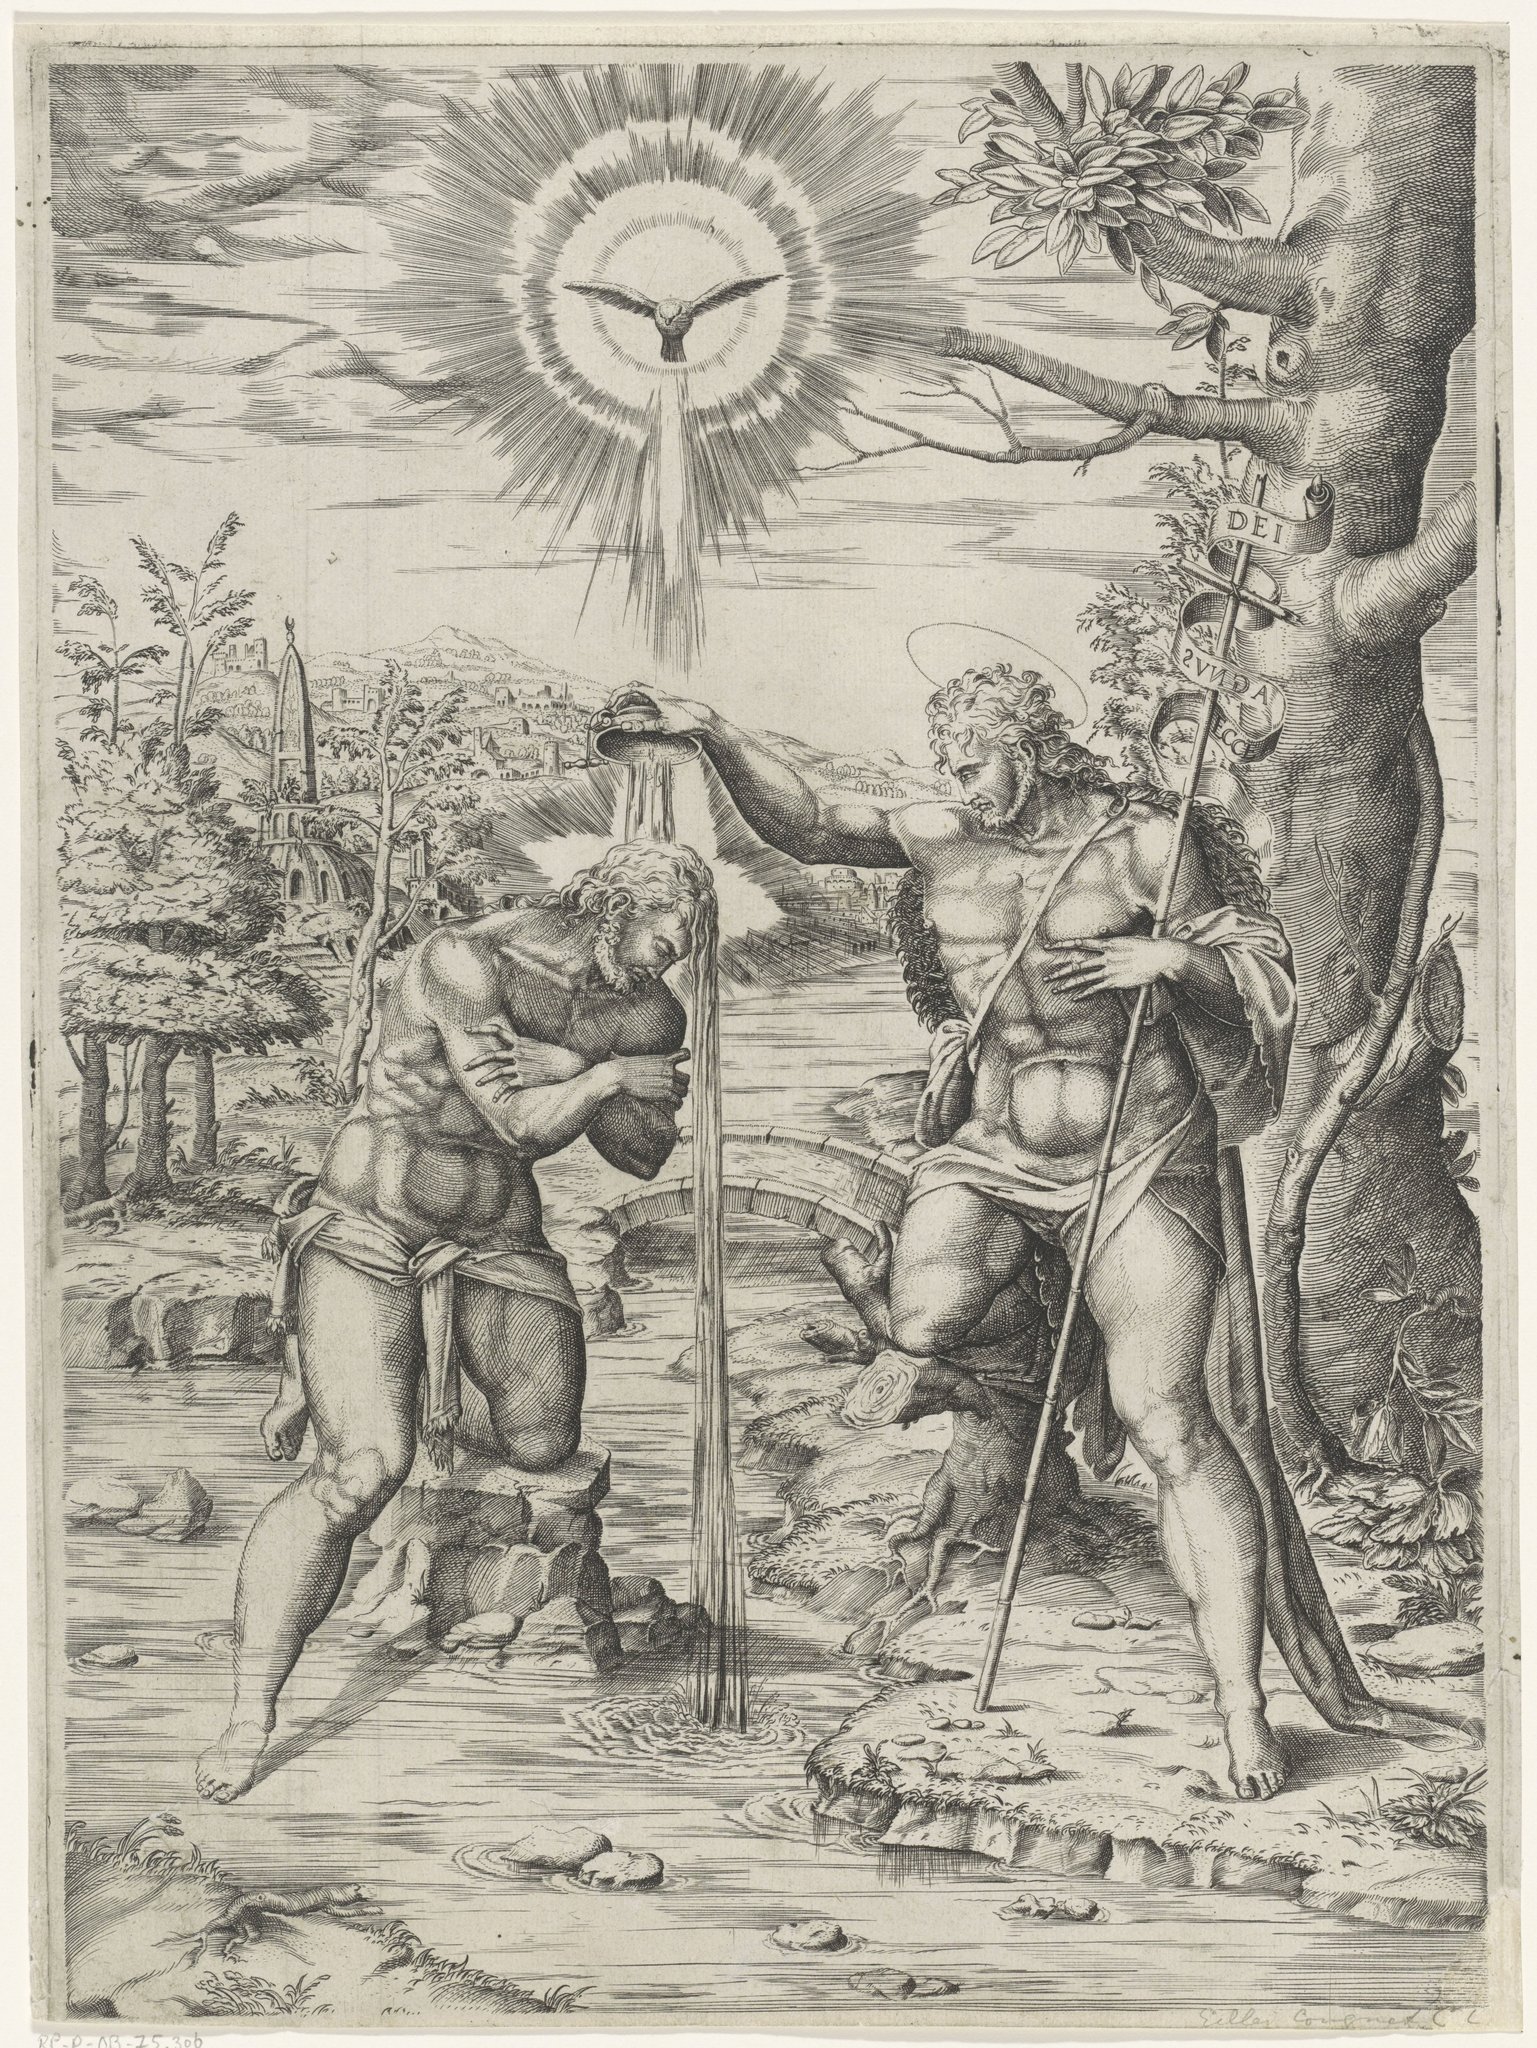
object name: print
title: Doop van Christus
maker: Anonymous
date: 1540-1580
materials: paper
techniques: engraving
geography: netherlands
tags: baptism of christ in the river jordan: john the baptist pouring out water on christ's head: the holy ghost descends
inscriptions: collector's mark: Lugt 2228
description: Johannes de Doper doopt Christus in de Jordaan. De Heilige Geest daalt als een duif neer. Christus buigt het hoofd en knielt met een been op een rotsblok. Johannes giet met behulp van een schelp water over Christus' hoofd en houdt een staf in de hand met daaraan een banderol met de tekst: Ecce Agnus Dei. Johannes laat een knie rusten op een boomstronk. Op de achtergrond een brug en in het heuvelachtige landschap een stad.